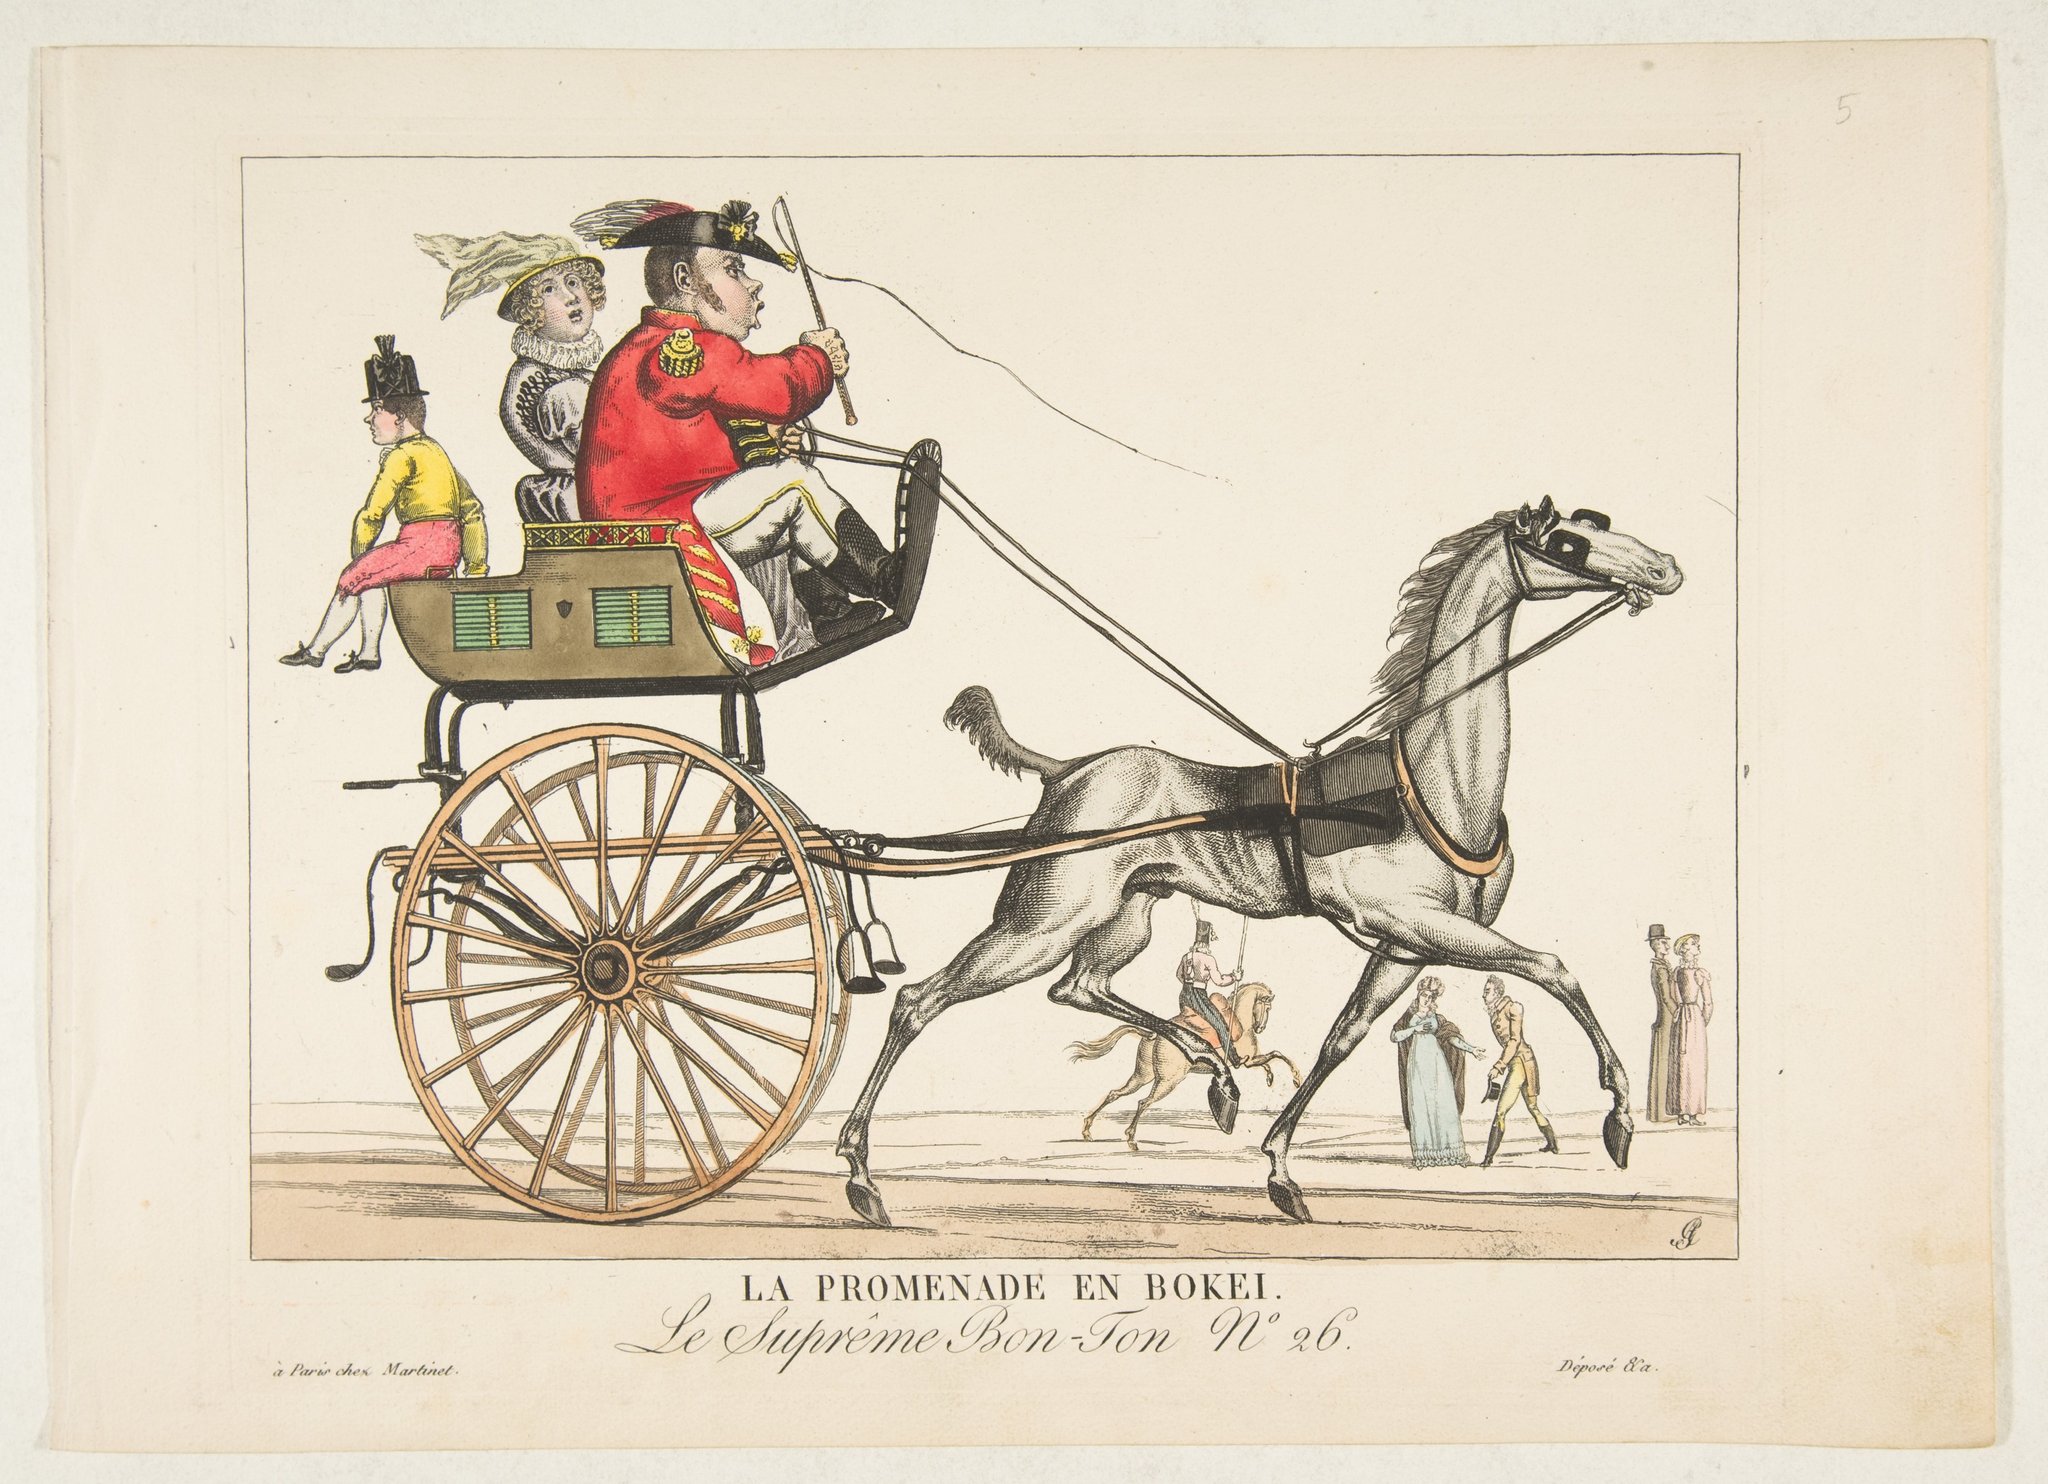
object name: print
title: La Promenade en Bokei; Le Suprême Bon-Ton No. 26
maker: adrien pierre godefroy, le jeune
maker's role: artist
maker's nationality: french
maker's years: 1777-1865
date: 1816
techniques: etching, hand coloring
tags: men,women,horses,carriages,caricature